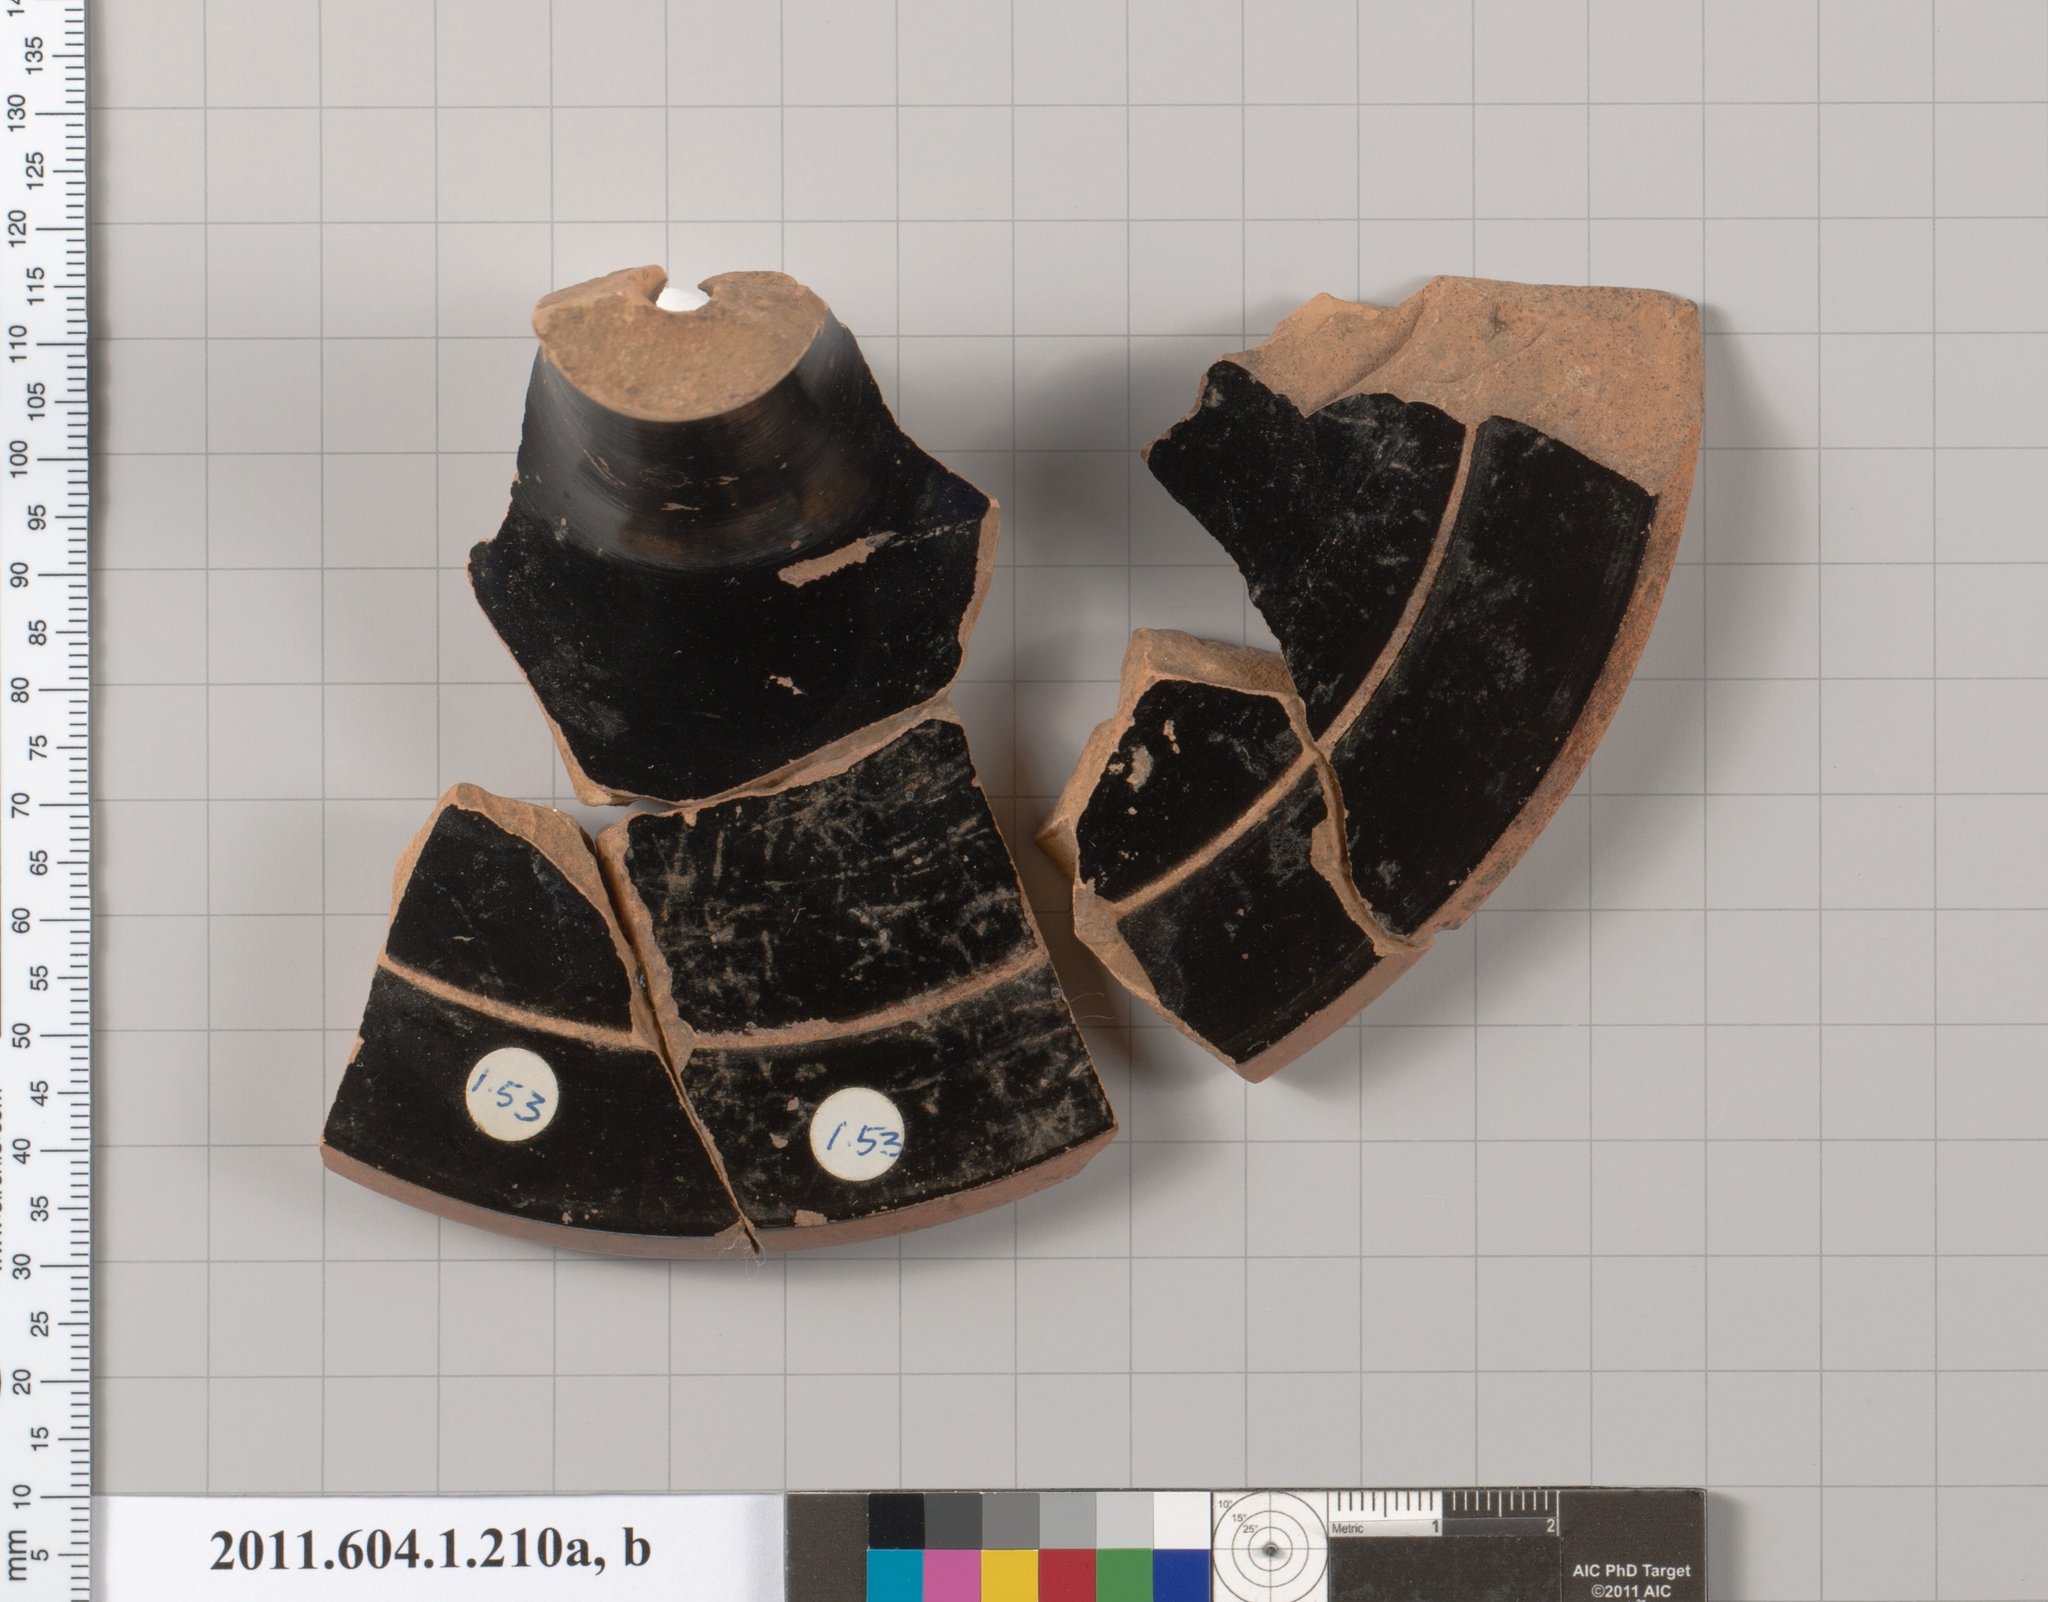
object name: kylix fragment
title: Terracotta fragments of a kylix (drinking cup)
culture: greek, attic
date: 475-451 BCE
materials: terracotta